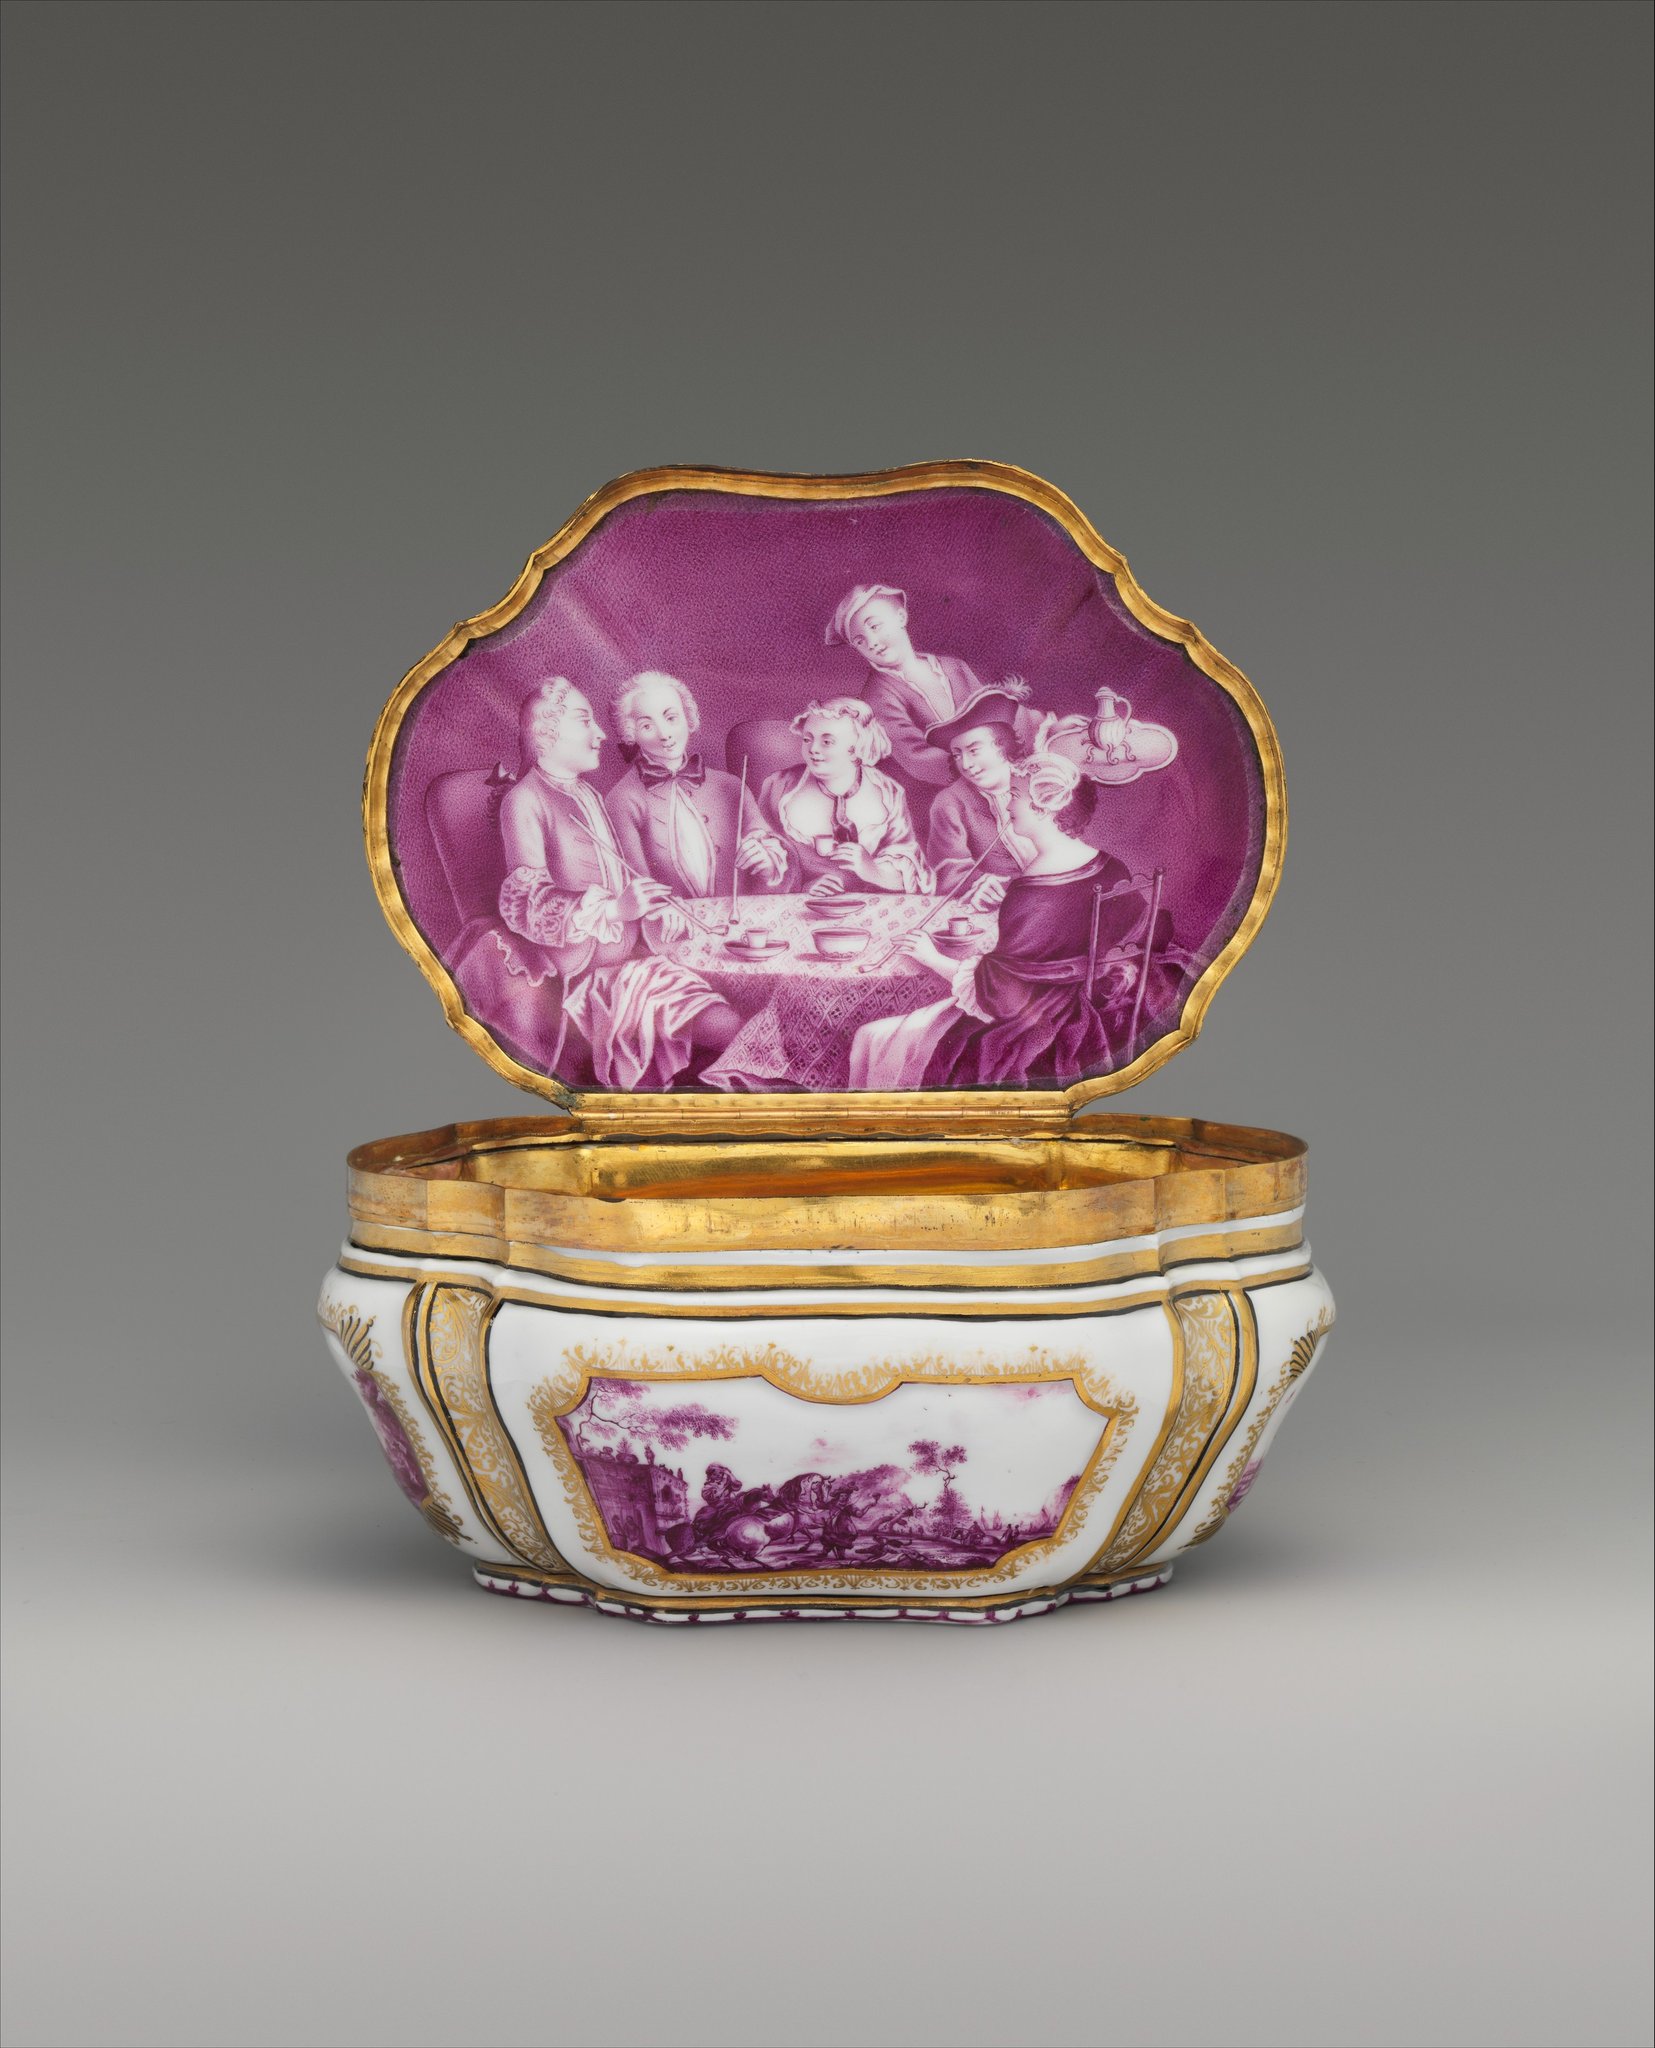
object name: table snuffbox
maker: meissen manufactory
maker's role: manufactory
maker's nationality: german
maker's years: 1710-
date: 1750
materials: gilt copper, hard paste porcelain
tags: men,women,party,smoking